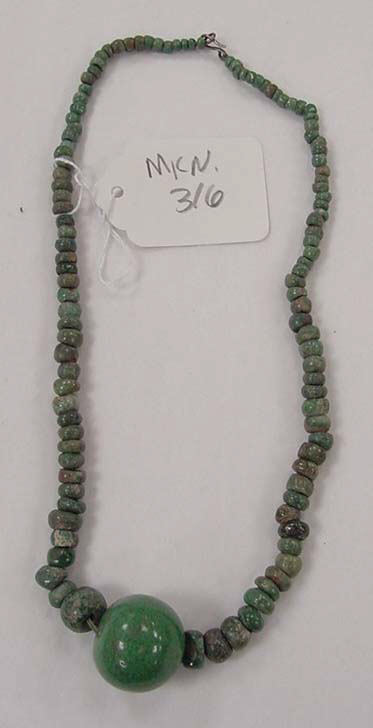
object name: necklace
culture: indigenous american or costa rican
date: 500 BCE-900 CE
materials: jade